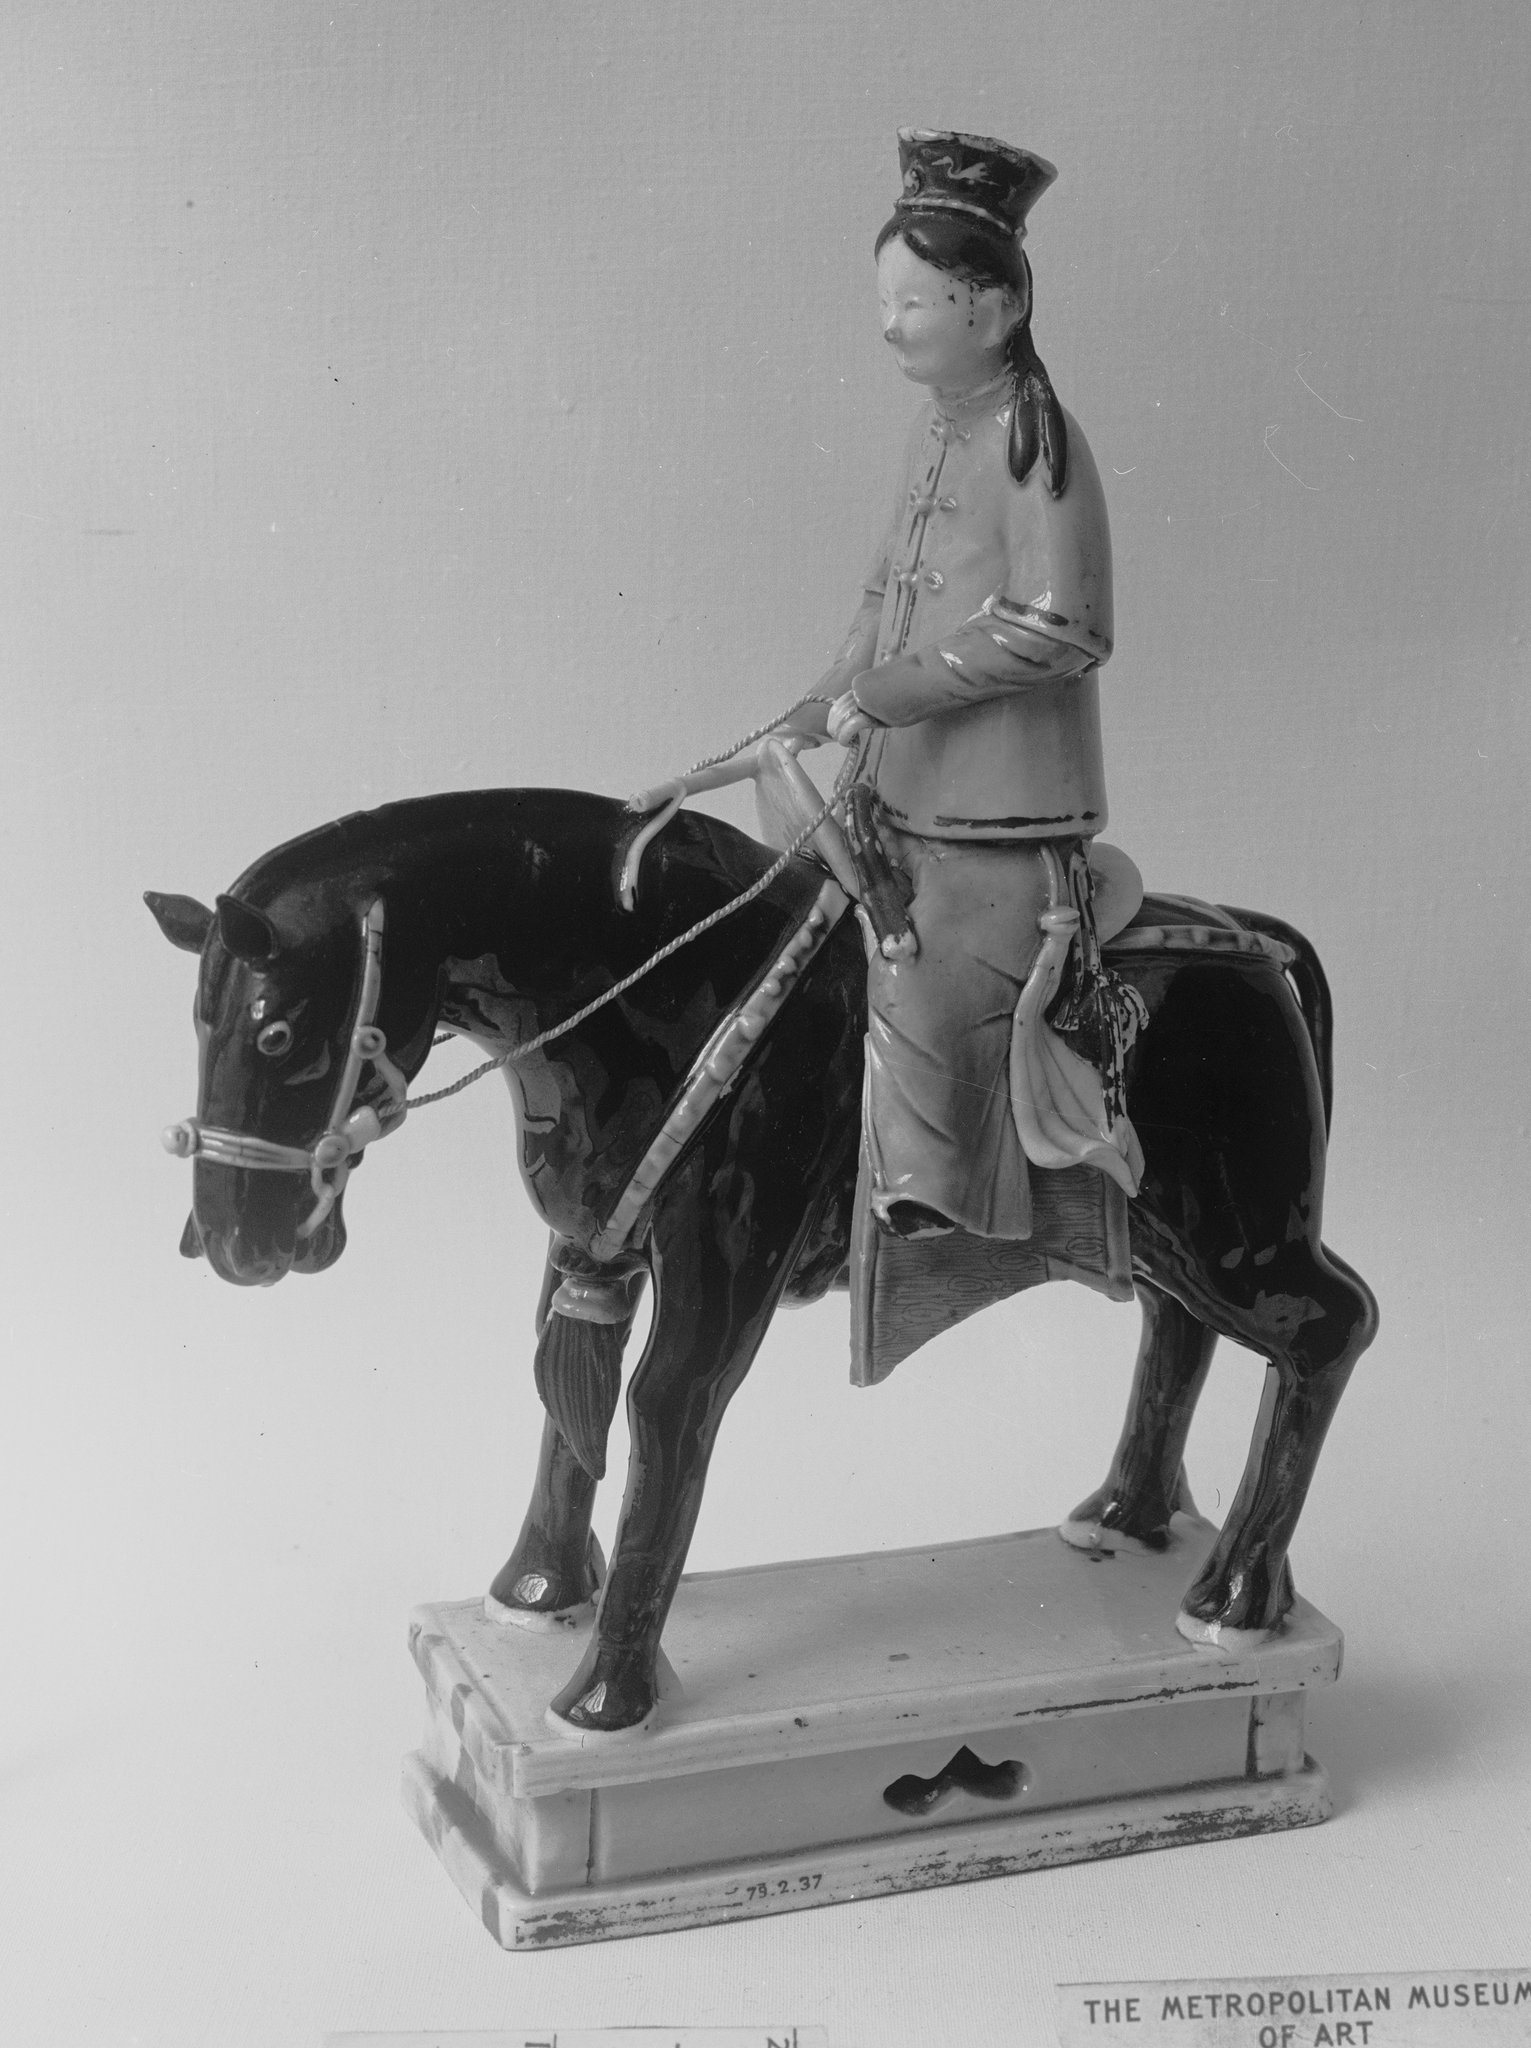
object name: figure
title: Figure of Lady on Horseback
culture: chinese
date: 1667-1733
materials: glaze, porcelain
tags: women,horses